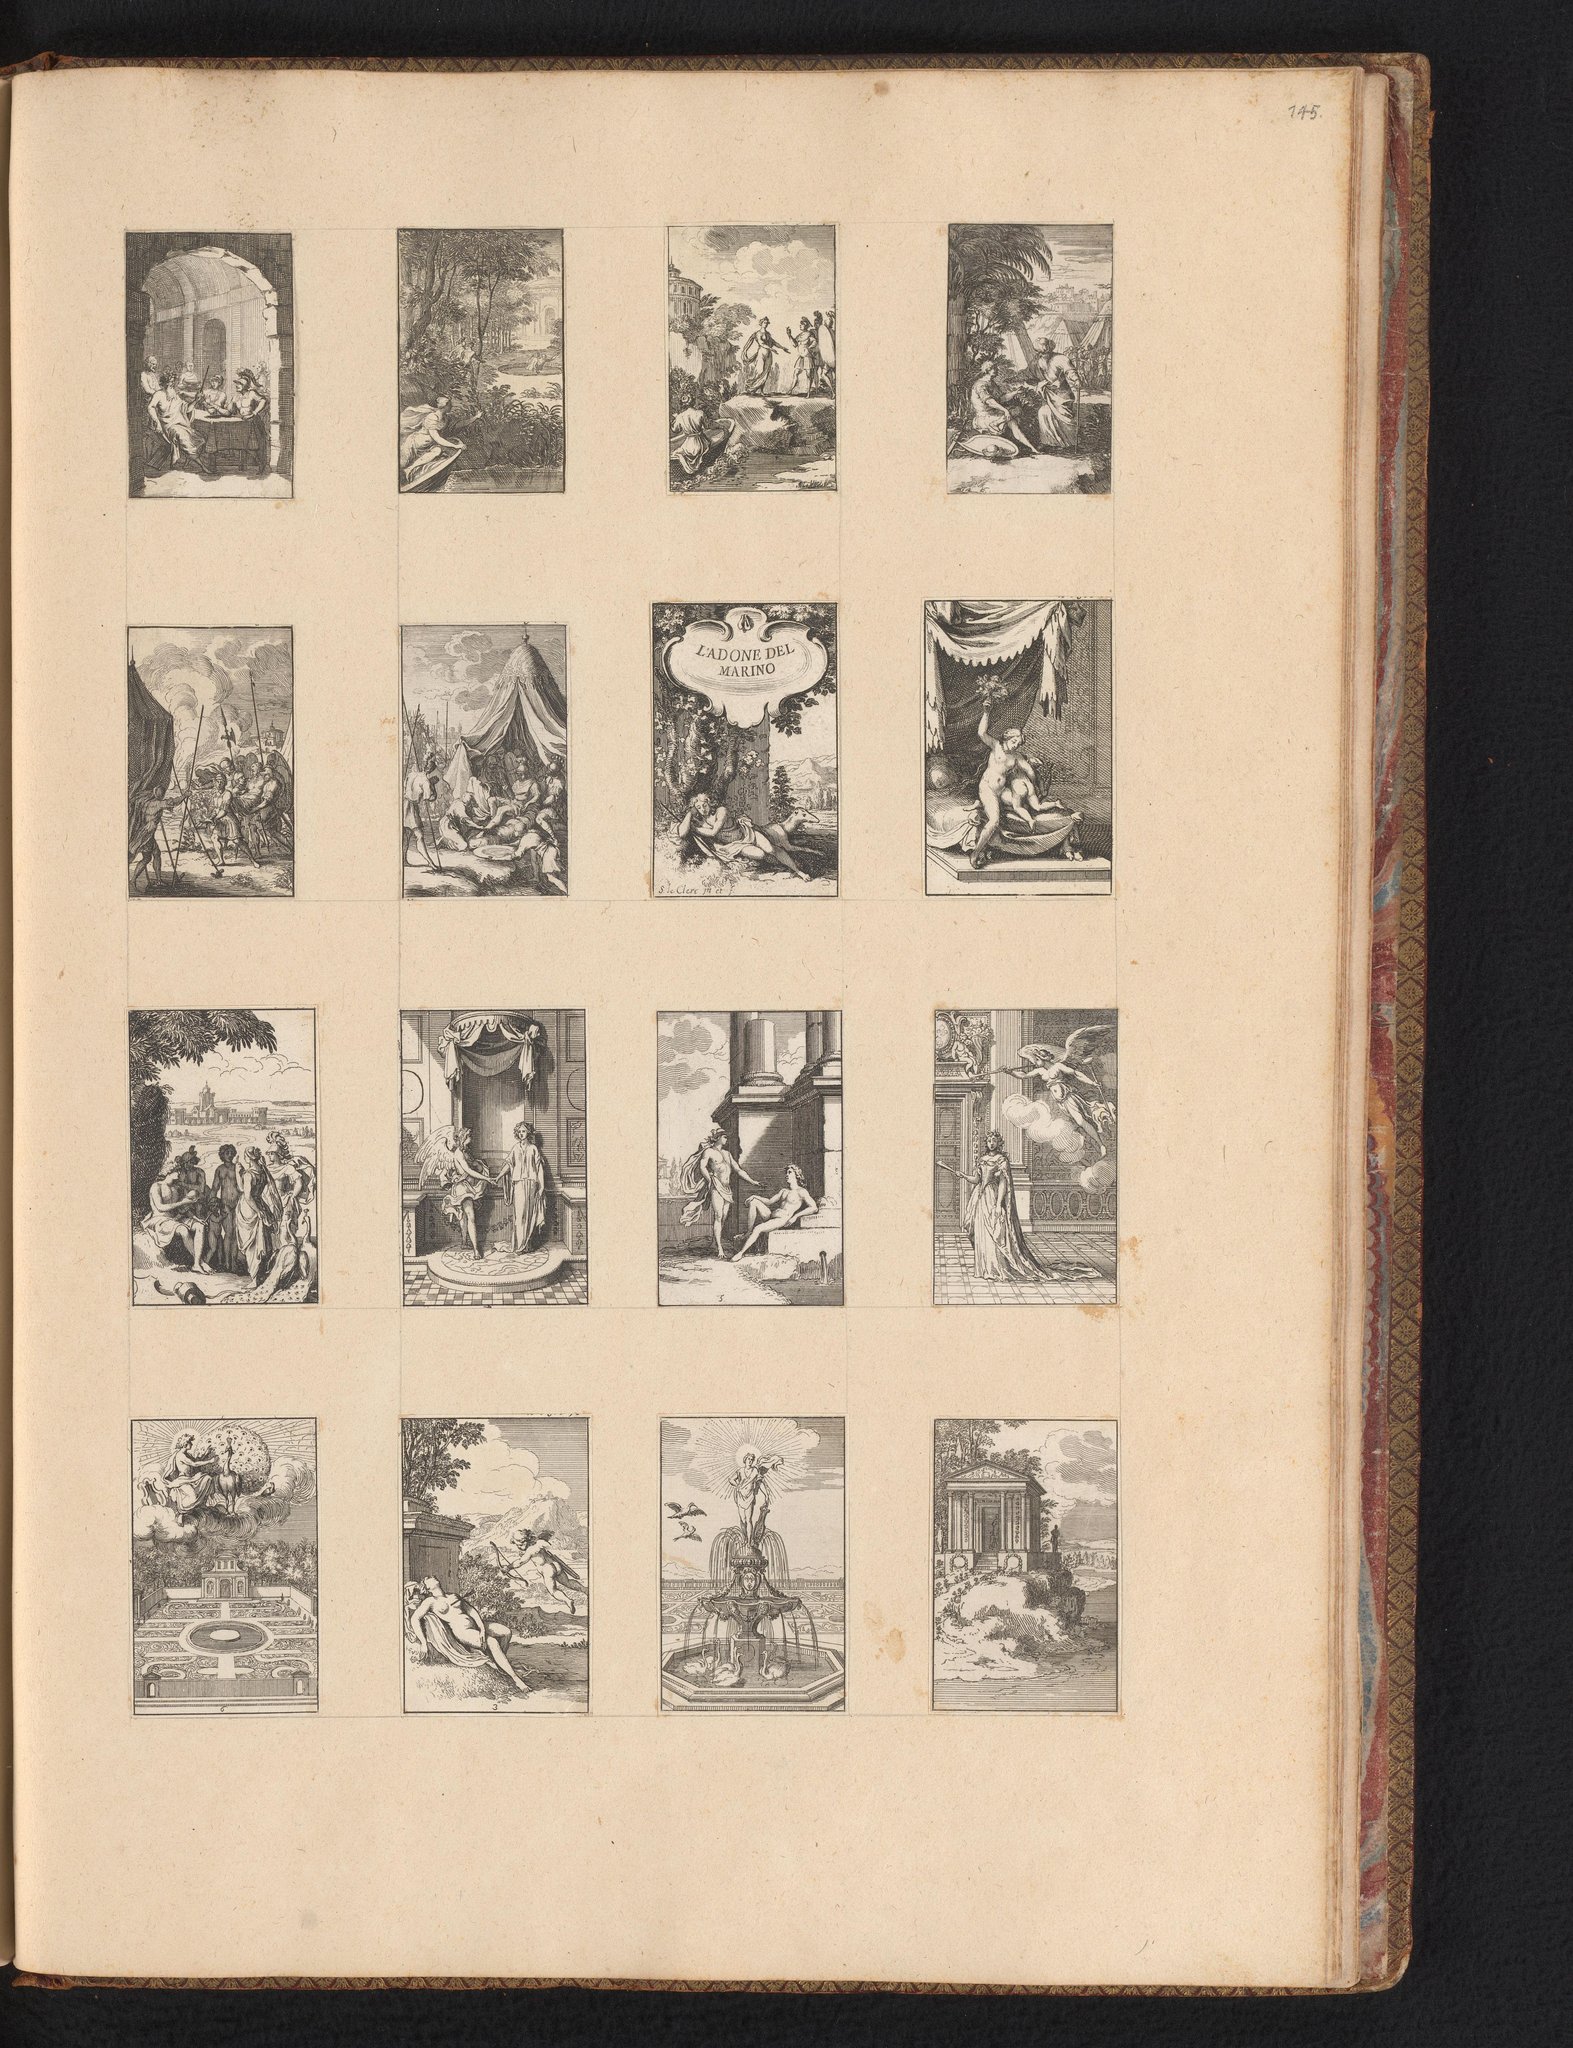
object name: print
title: Zes prenten uit Tasso's 'Gierusalemme liberata (...)' en tien prenten uit Marino's 'L'Adone, poeme heroico (...)'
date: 1678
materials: paper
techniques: etching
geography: amsterdam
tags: (story of) adonis, militant proselytizing: religious war, crusade, etc.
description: Deze zestien prenten maken deel uit van een album.